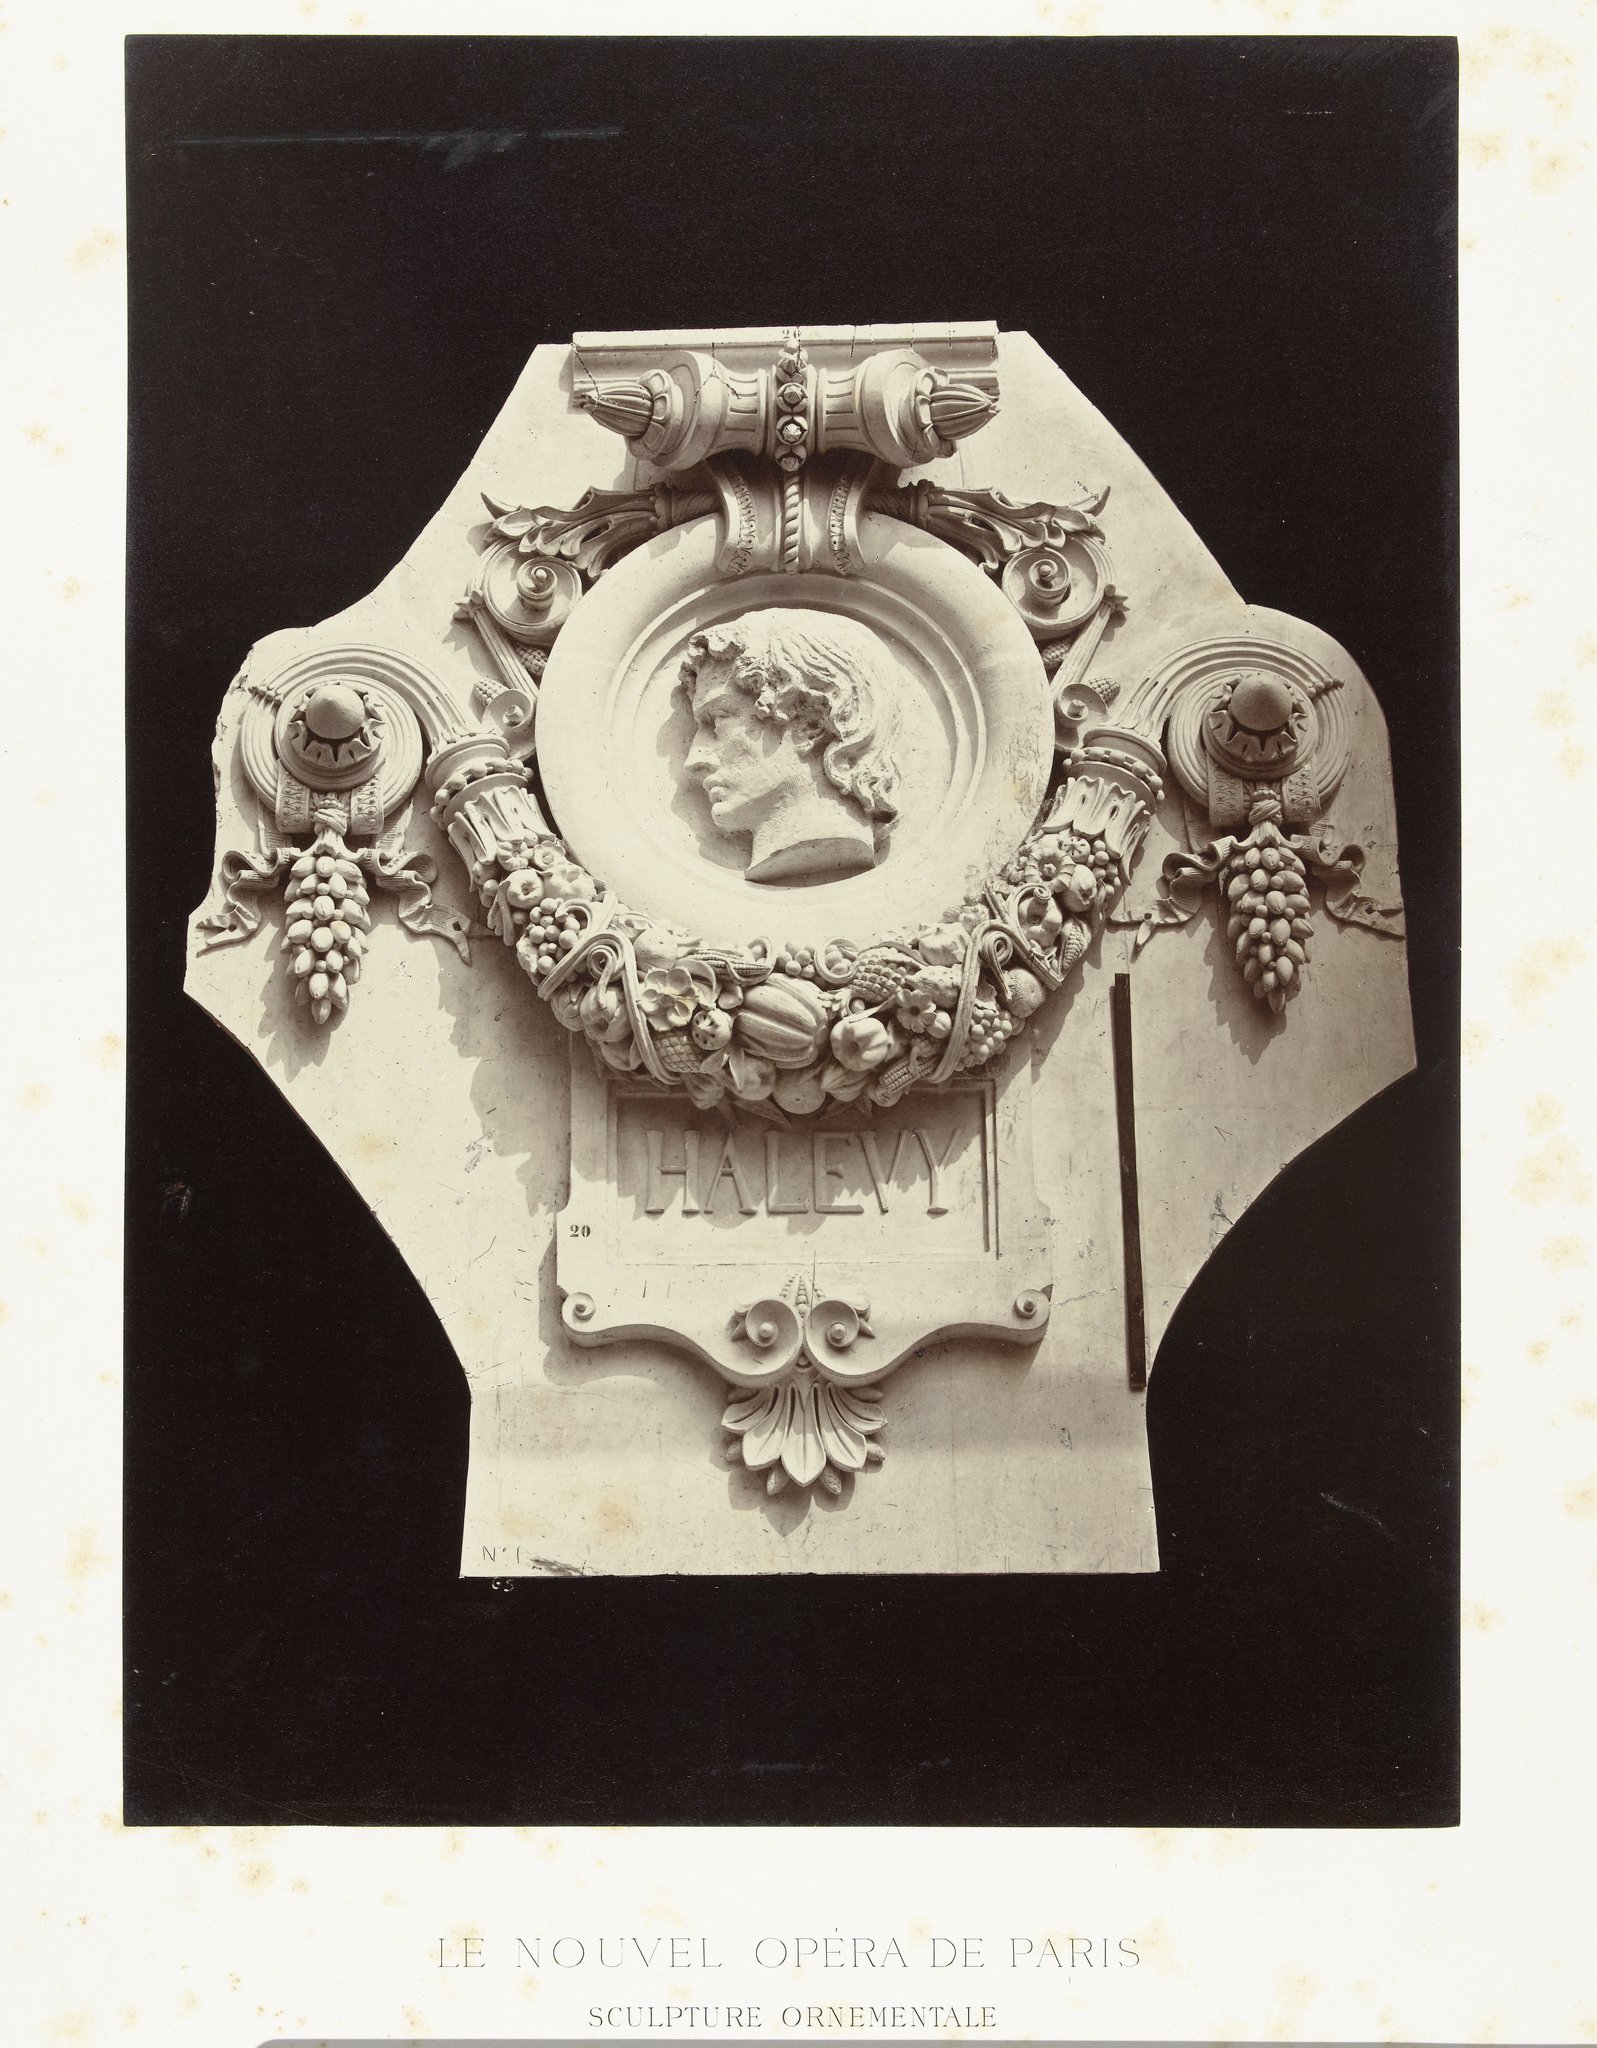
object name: photograph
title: 1. Le nouvel Opéra de Paris. Sculpture Ornamentale.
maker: louis-emile durandelle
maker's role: fotograaf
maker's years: 1839-1917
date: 1878-1881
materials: photographic support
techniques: albumen print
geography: paris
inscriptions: number: ‘34’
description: bij boek in Bibliotheek RMA, Zie Frizot, pp. 217-223, vgl G. Vicaire, Manuel de l'amateur de livres du XIXe siècle, vol. 3, column 870.